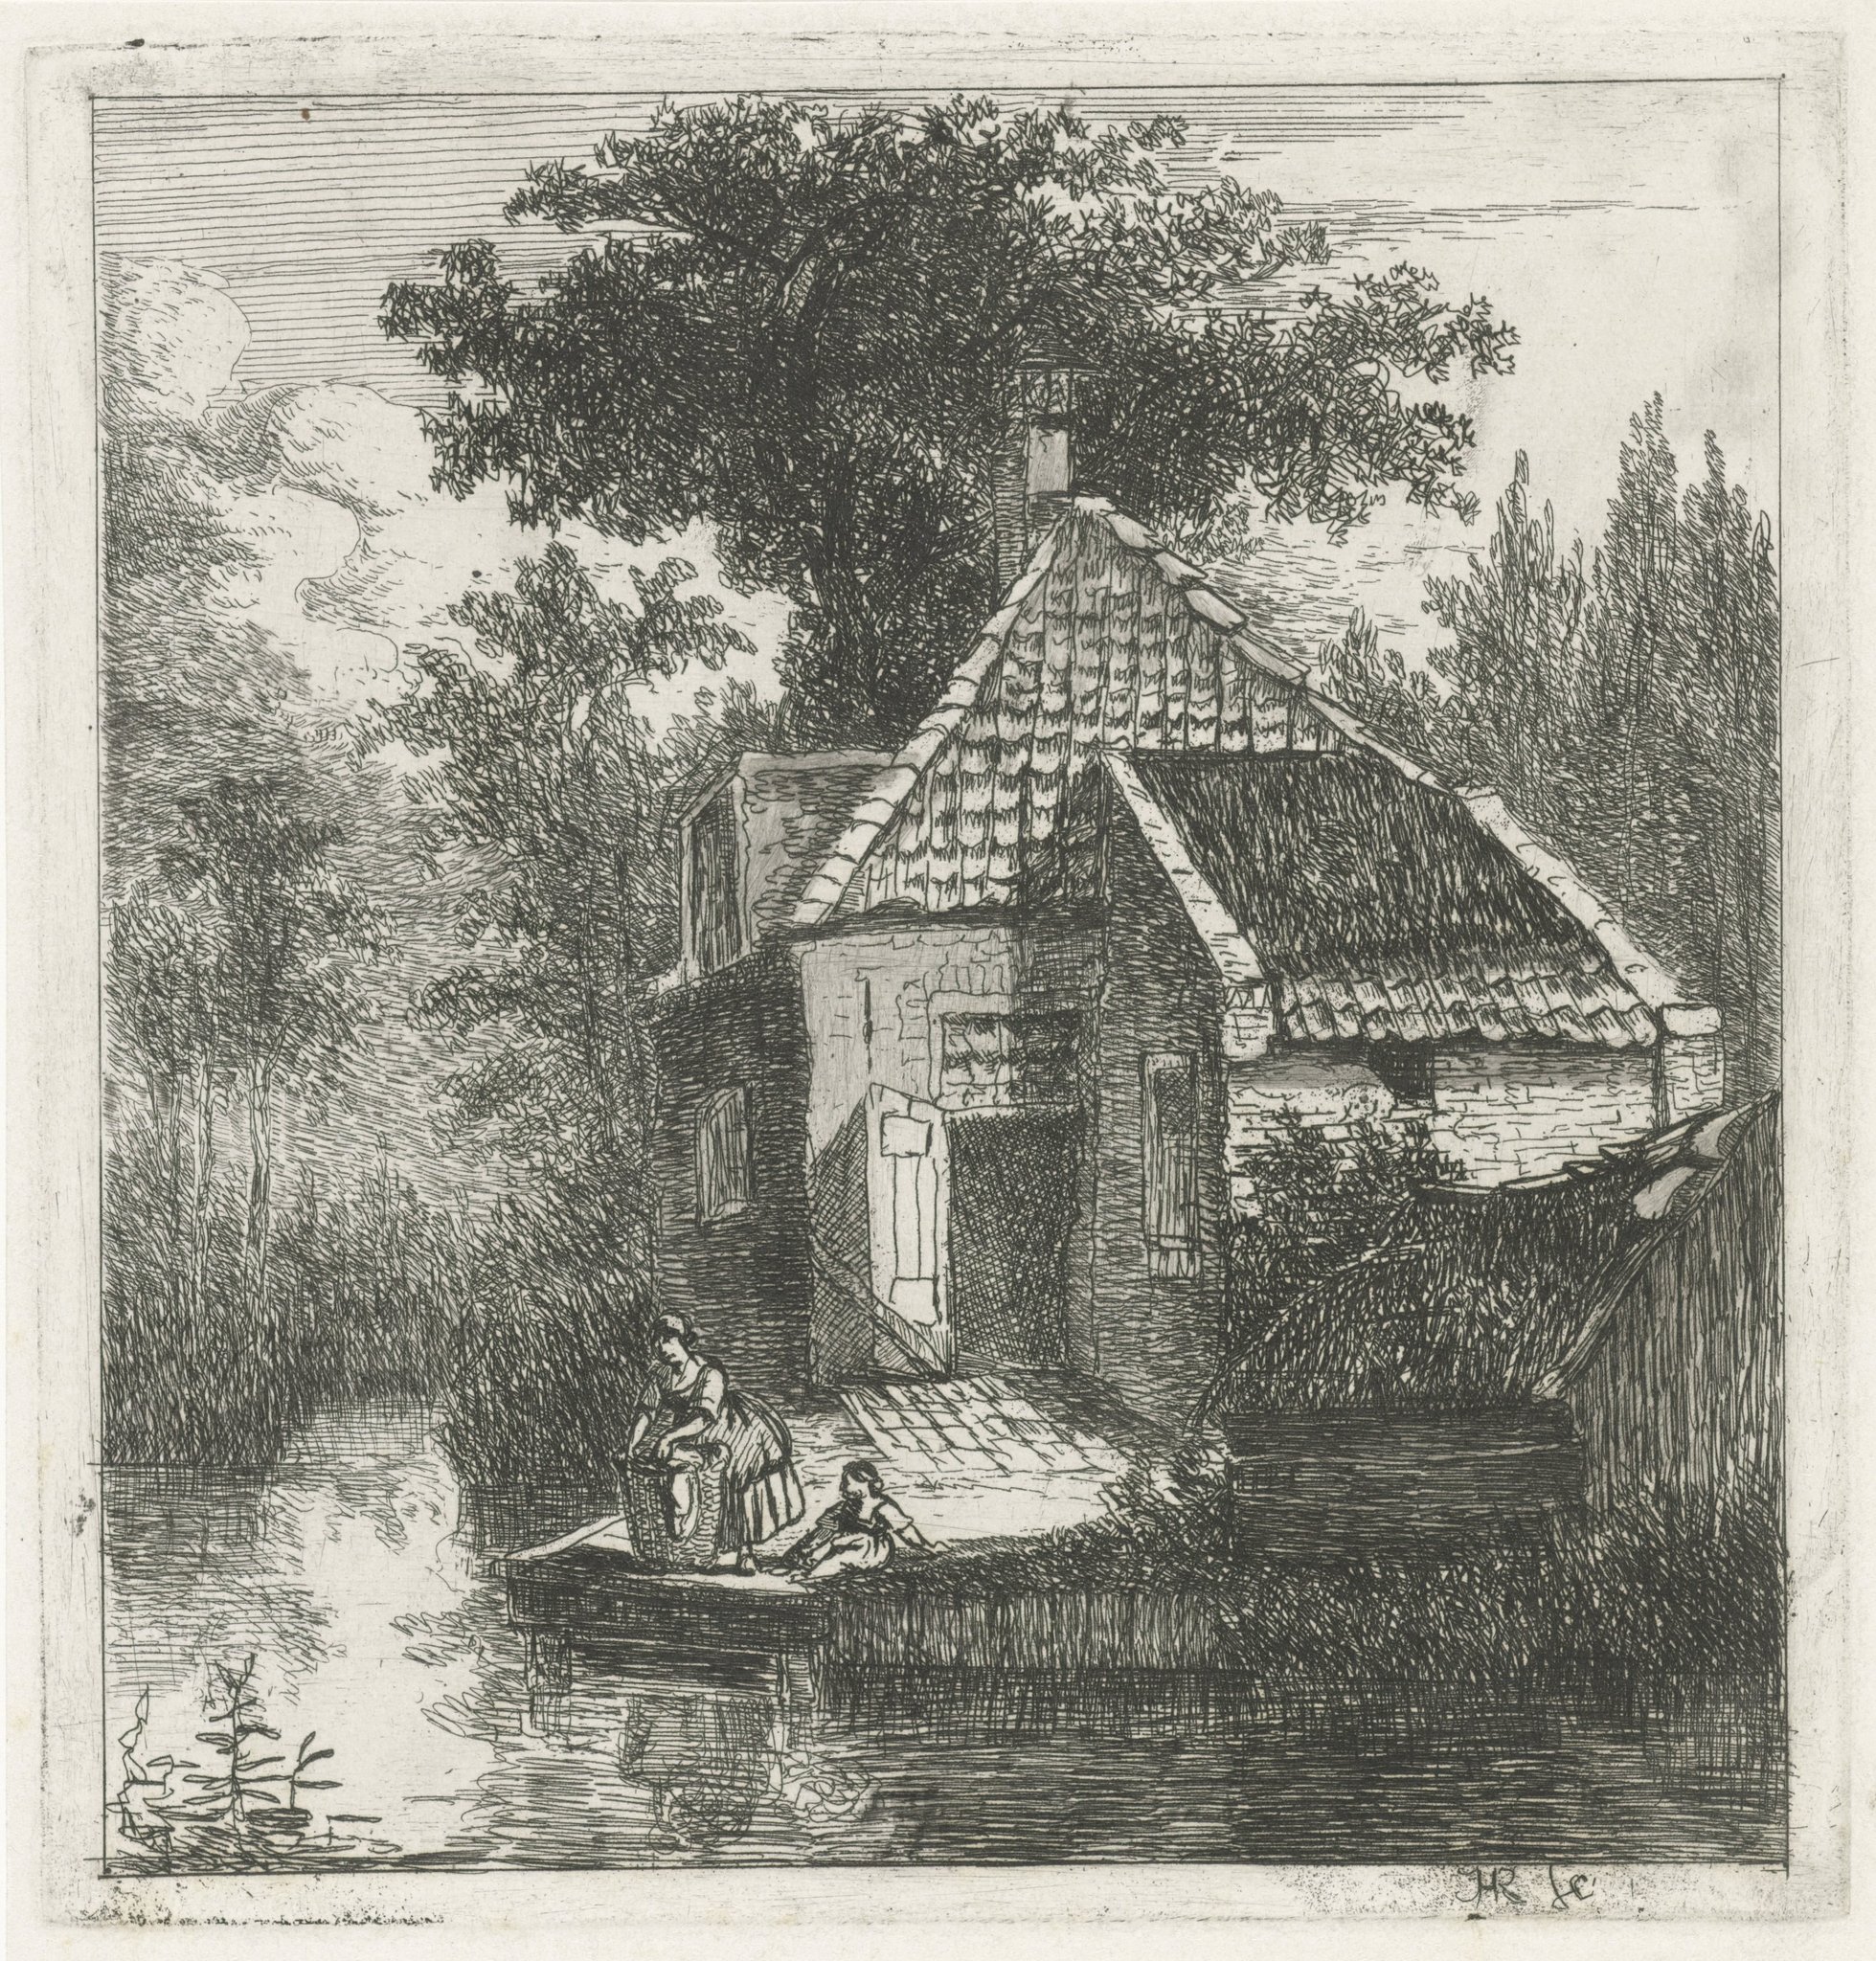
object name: print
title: Vrouw met een wasmand en een kind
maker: hermanus jan hendrik van rijkelijkhuysen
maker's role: painter, print maker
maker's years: 1813-1883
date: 1823-1883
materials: paper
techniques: etching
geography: utrecht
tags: brook, laundering, mother and baby or young child, farm or solitary house in landscape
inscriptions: collector's mark: Lugt 2228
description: Voor een aan het water gelegen huis staat een vrouw met een wasmand op een steiger. Naast haar zit een kind.